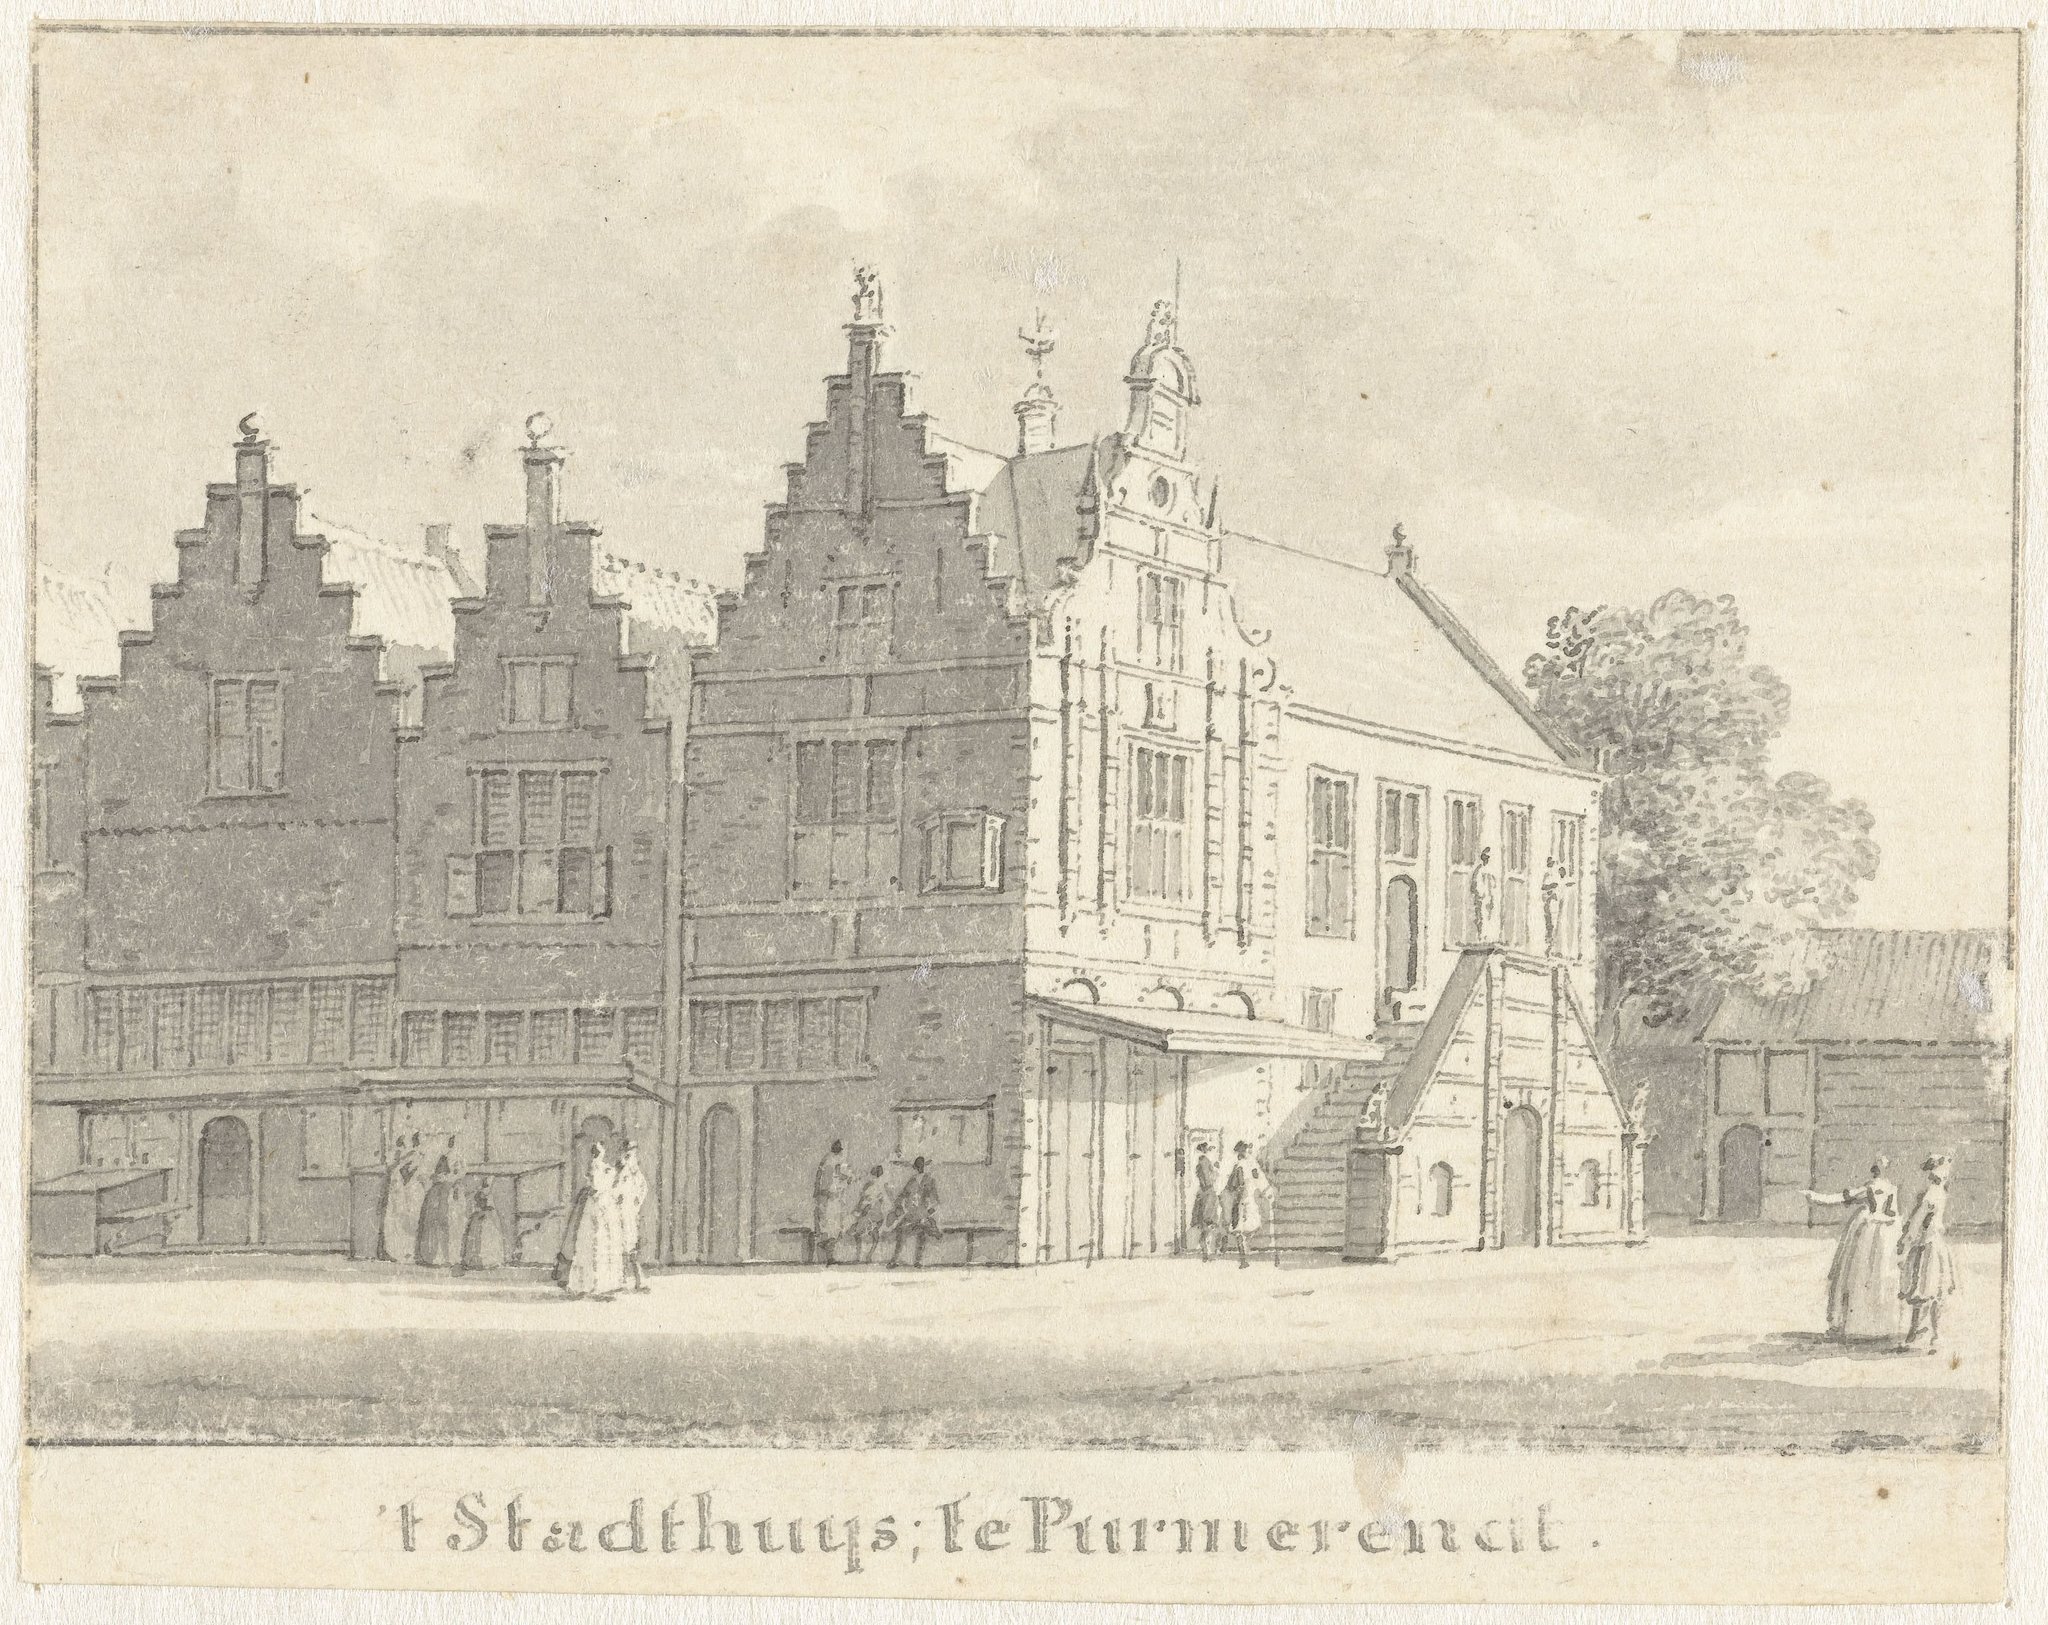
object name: drawing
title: Het stadhuis te Purmerend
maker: cornelis pronk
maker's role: draughtsman, painter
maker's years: 1691-1759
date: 1701-1759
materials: ink, paper, pencil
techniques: brush, pen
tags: townhall